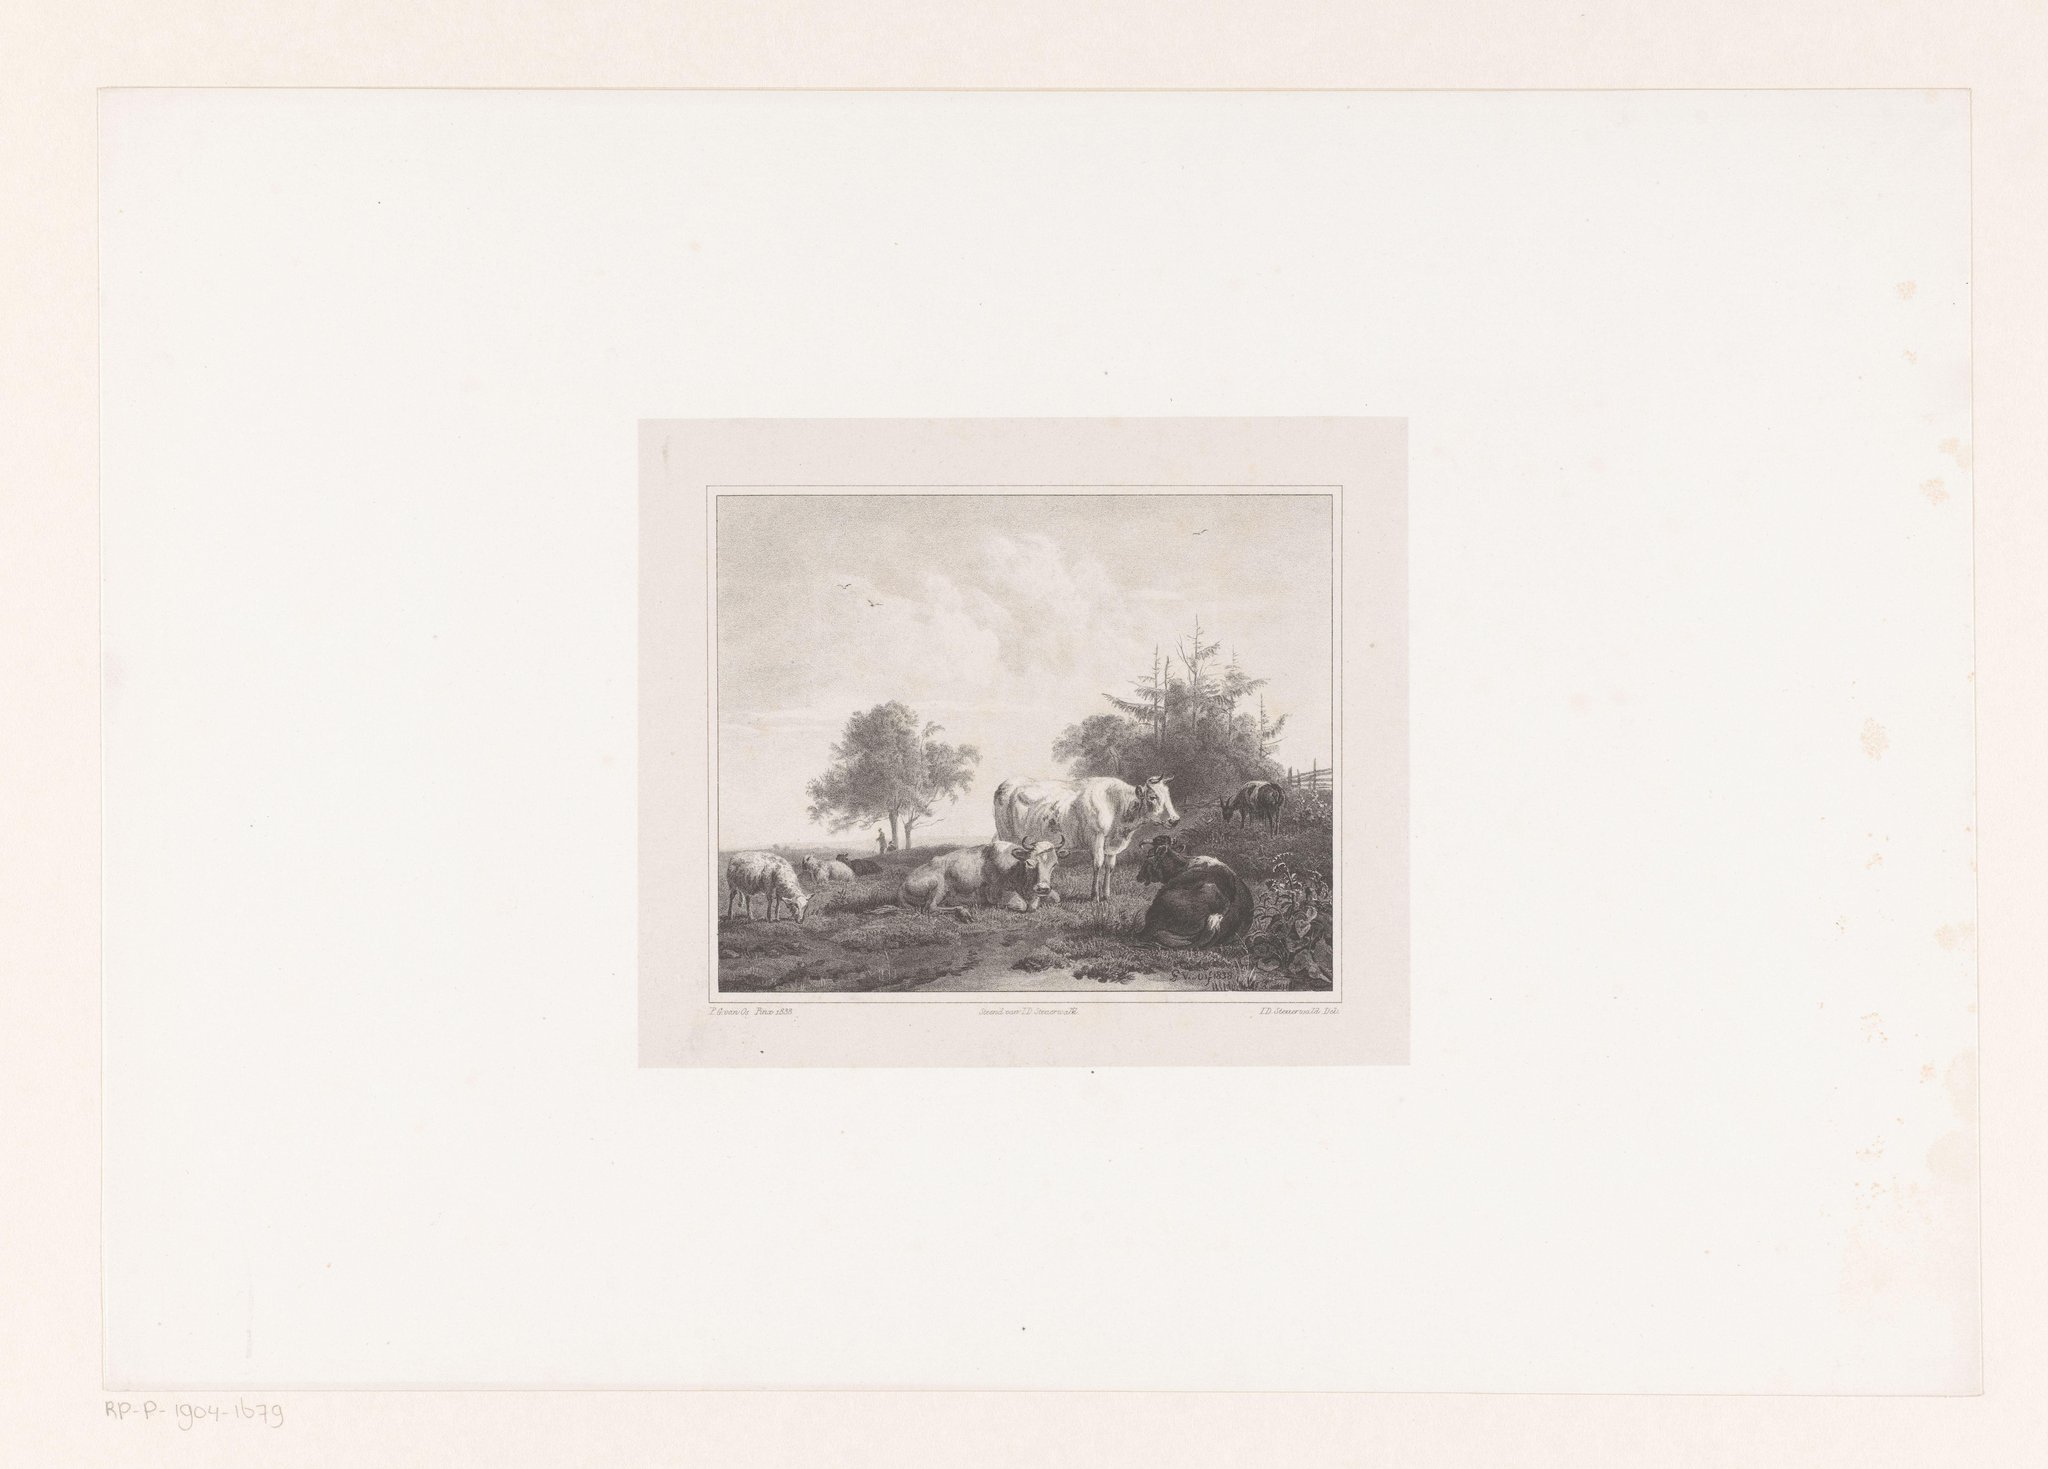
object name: print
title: Landschap met vee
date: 1838-1863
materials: paper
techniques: lithograph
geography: the hague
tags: cow, sheep, goat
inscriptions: collector's mark: Lugt 2228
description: In een veld twee liggende en een staande koe, schapen en geiten. In de achtergrond staat een figuur onder een boom.